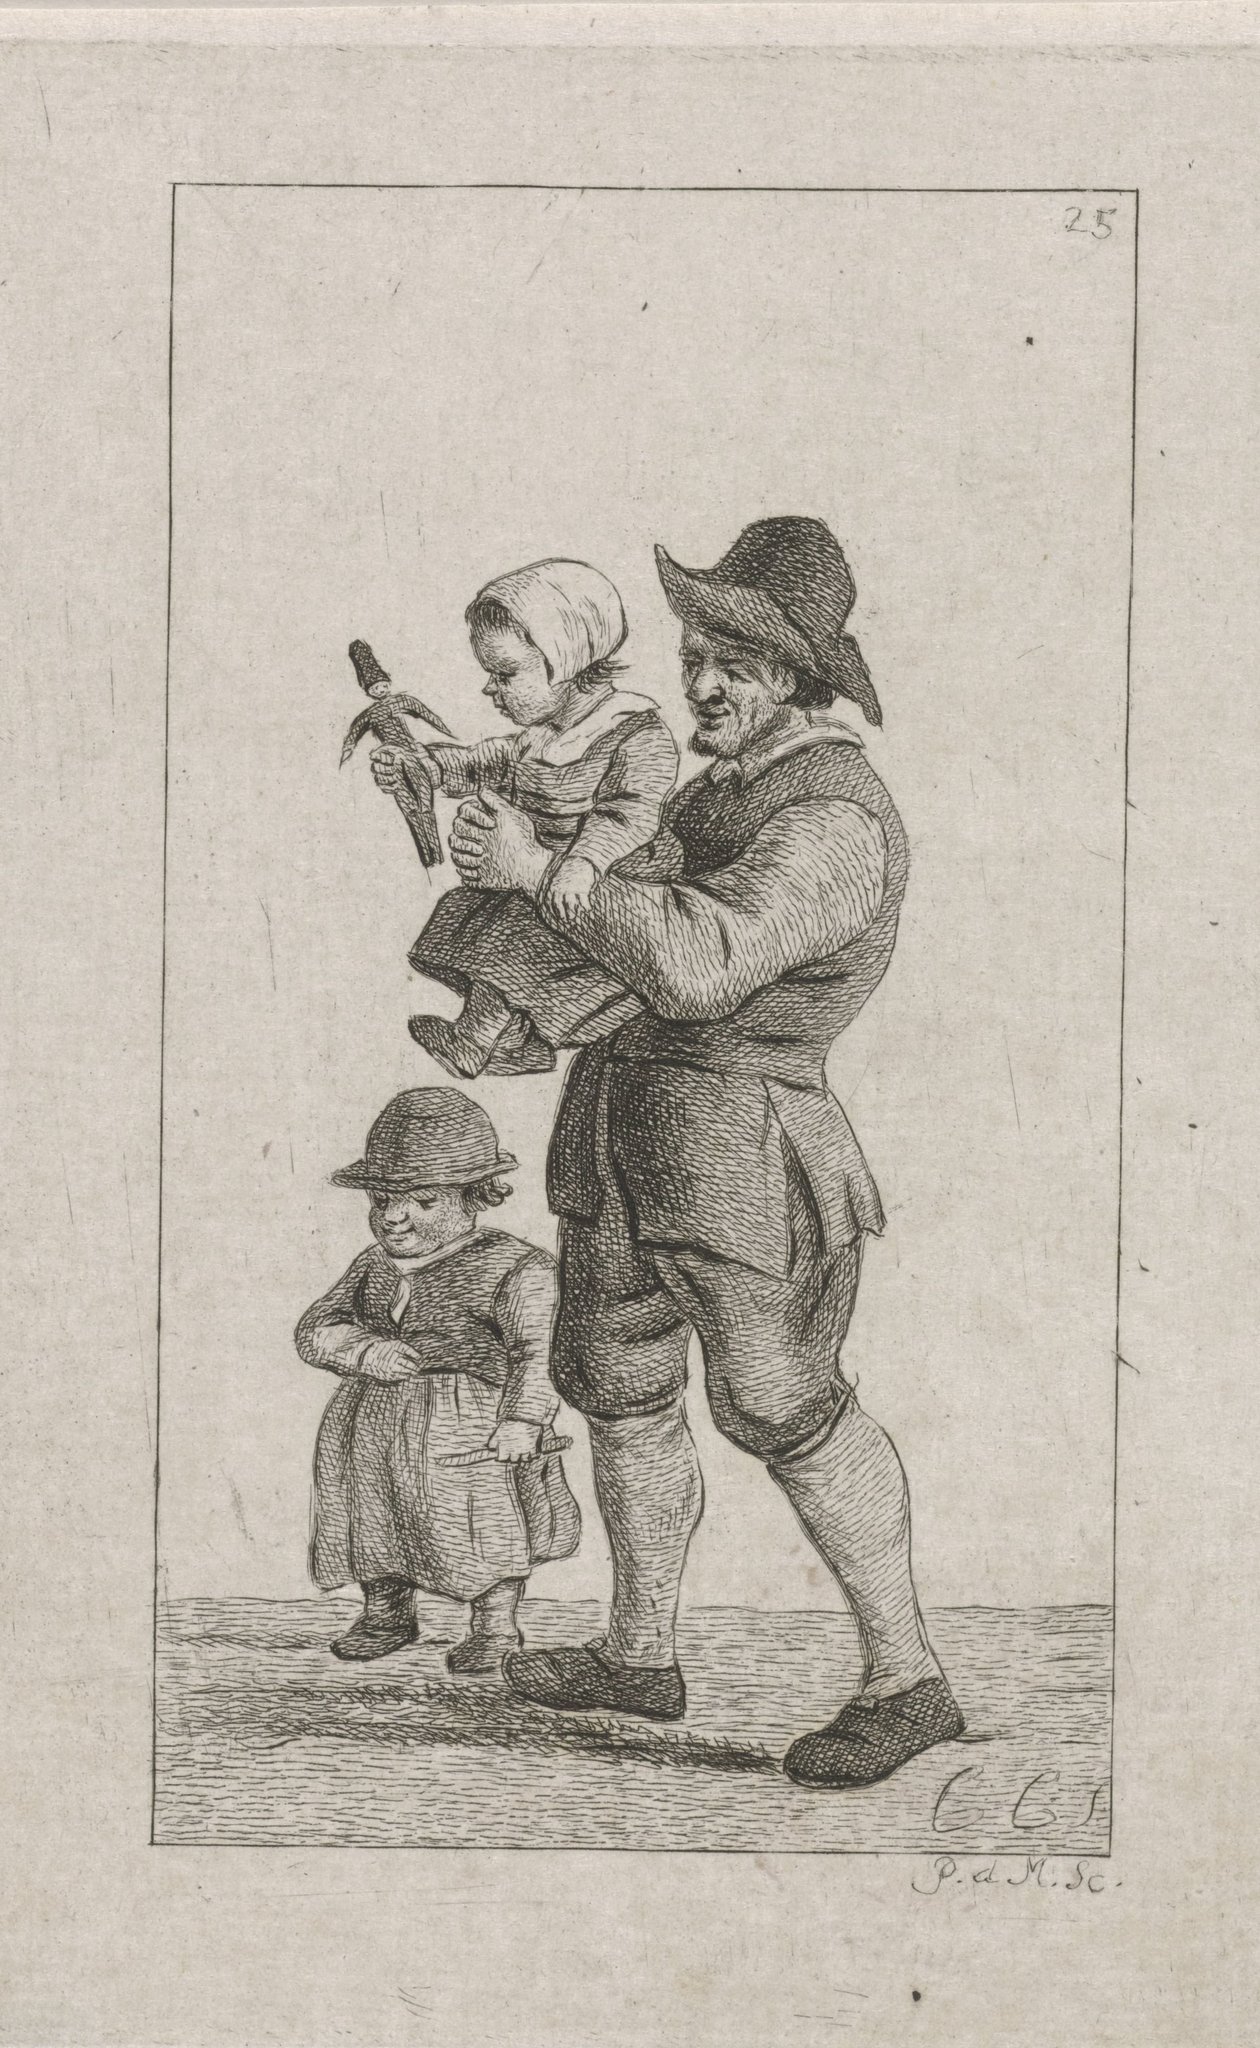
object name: print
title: Vader met twee kinderen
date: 1779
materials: paper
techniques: etching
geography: leiden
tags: father-love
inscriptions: collector's mark: Lugt 240